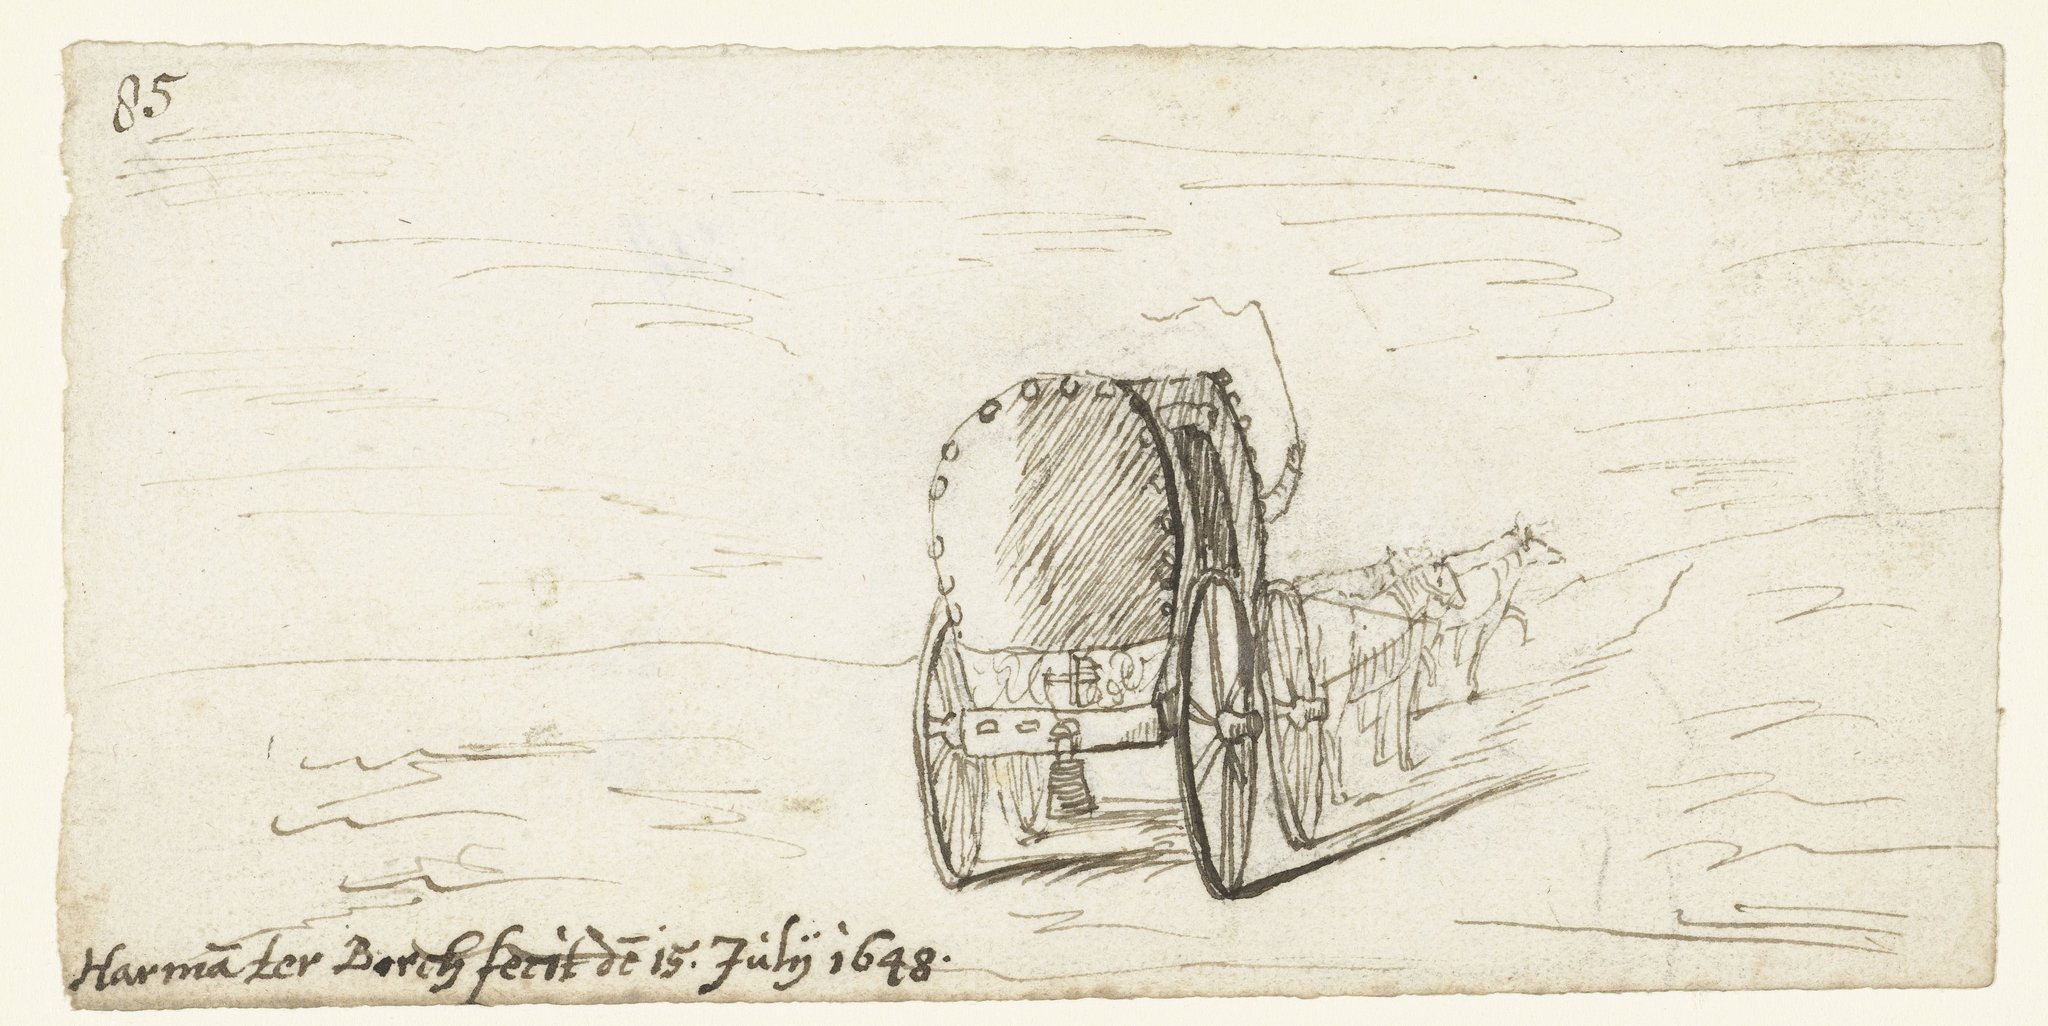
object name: drawing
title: Koets met het wapen van Zwolle, van achteren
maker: harmen ter borch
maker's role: draughtsman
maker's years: 1638-1677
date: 1648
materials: chalk, ink, paper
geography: zwolle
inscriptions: annotation: ‘Harma[n] ter Borch fecit de[n] 15.Julij 1648.’